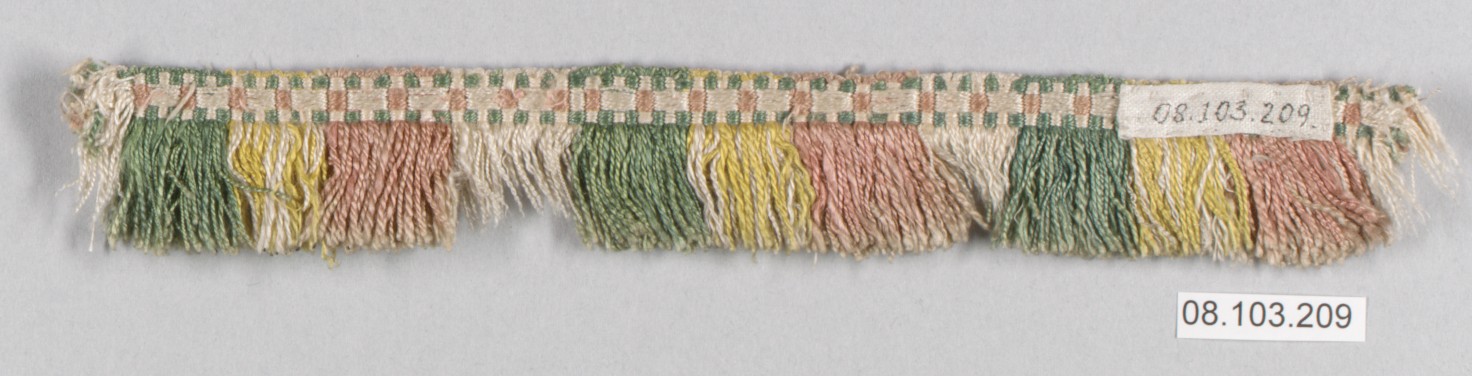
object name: fringe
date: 1701-1800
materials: cotton